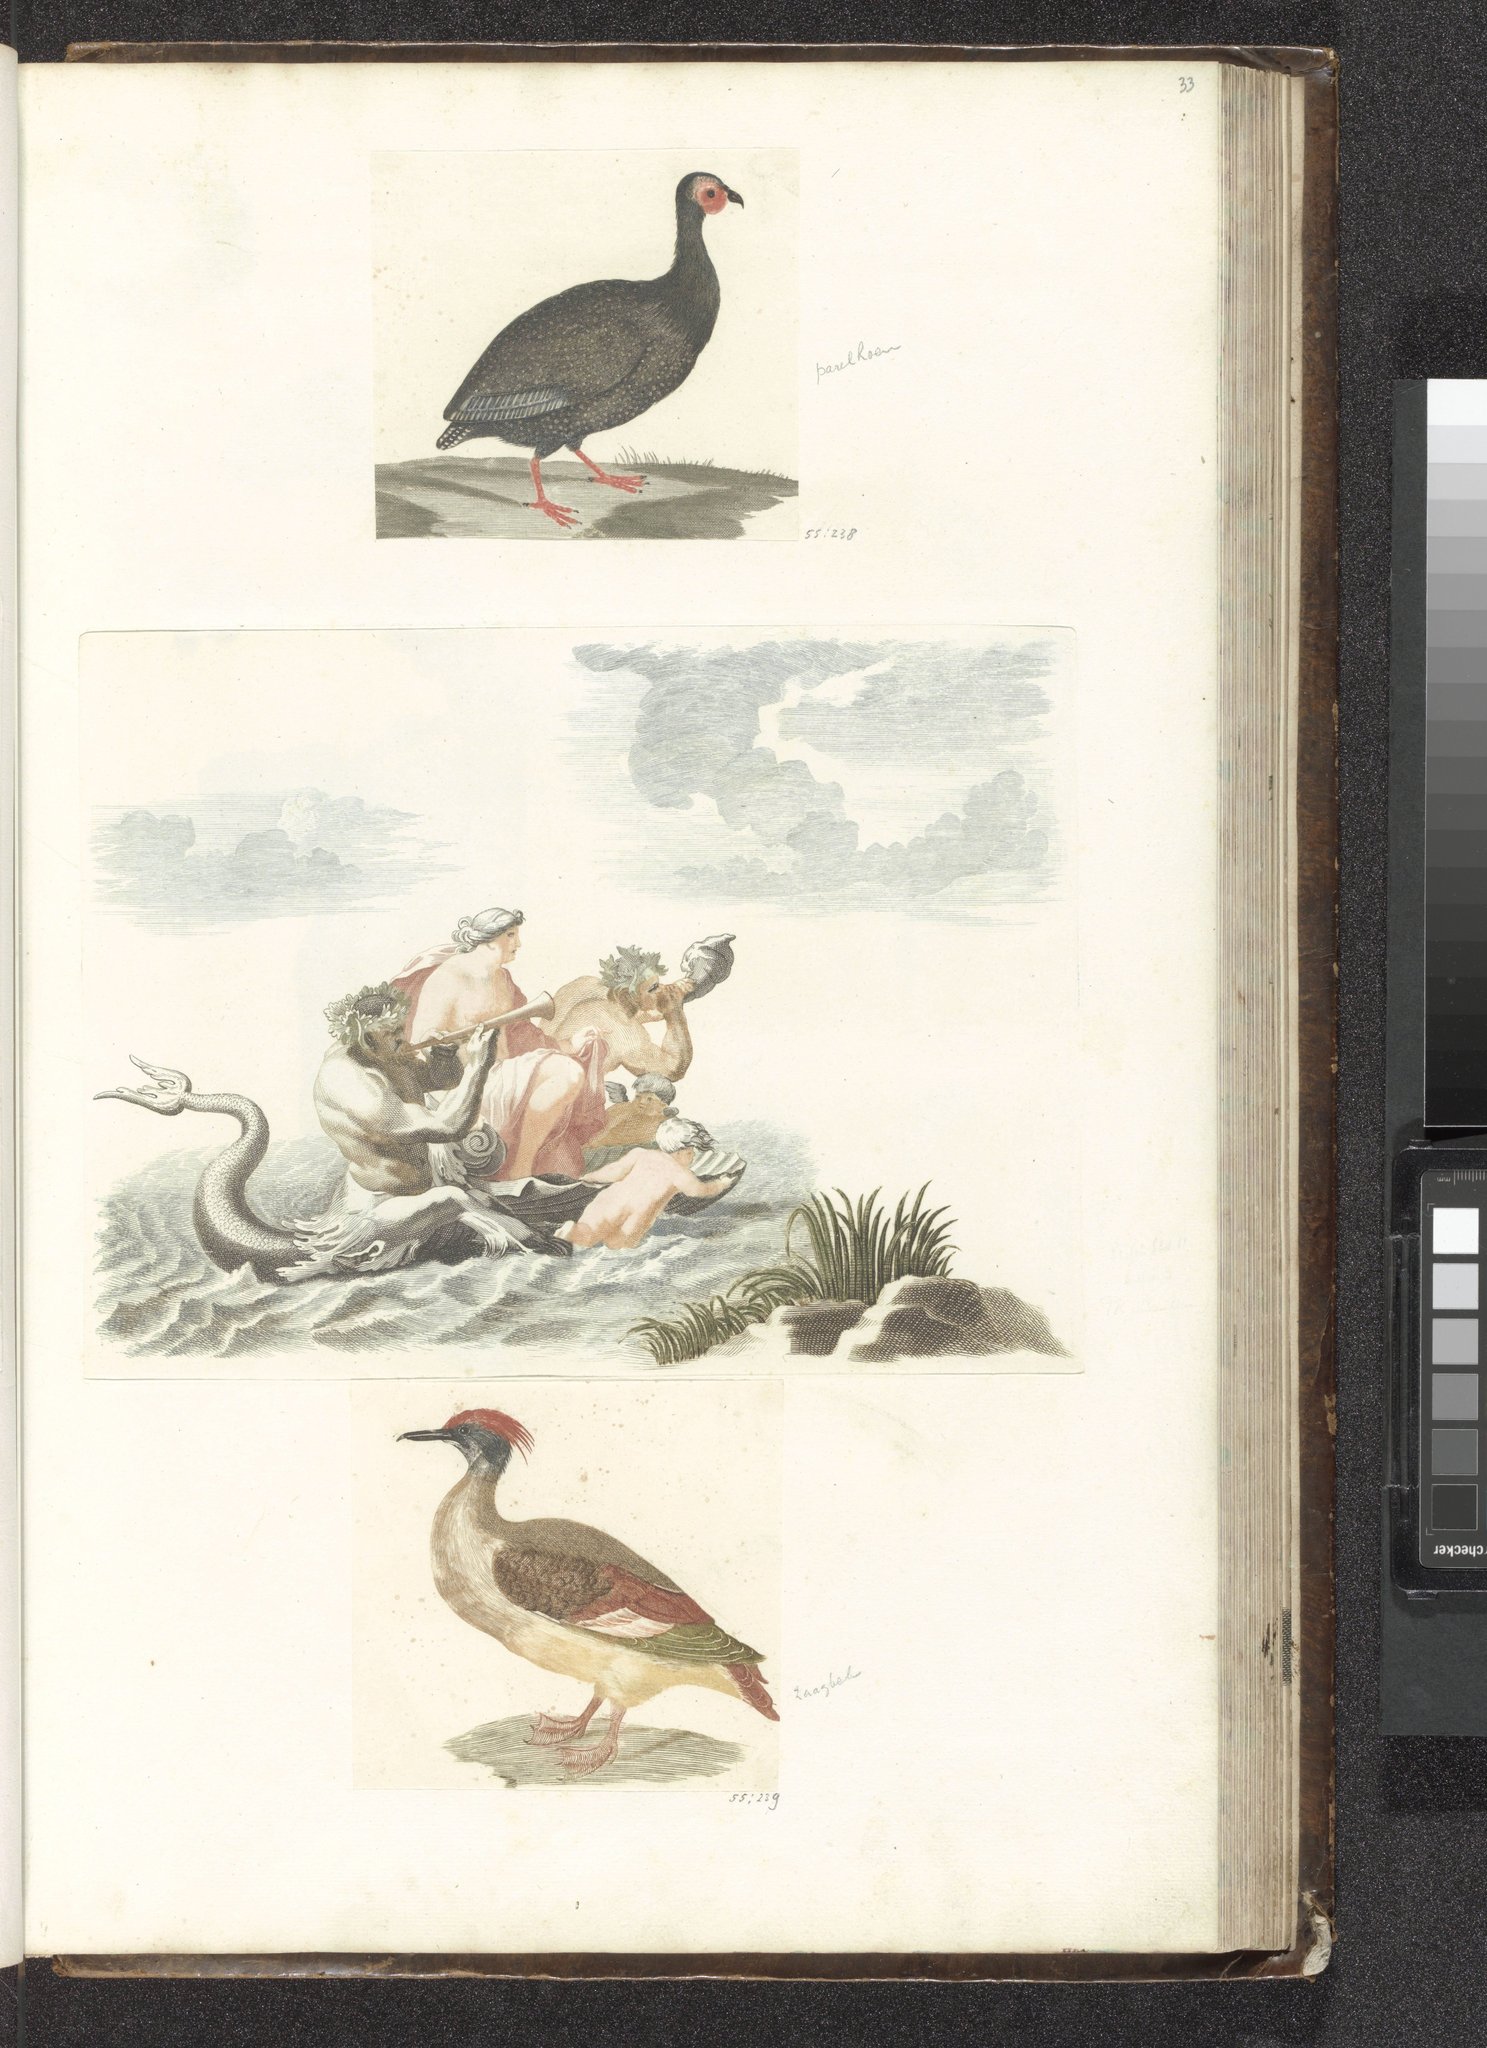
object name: album leaf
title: Zaagbek naar links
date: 1688-1698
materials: paper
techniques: printing, engraving, lithography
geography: netherlands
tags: water-birds: duck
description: Deze prent maakt deel uit van een album.